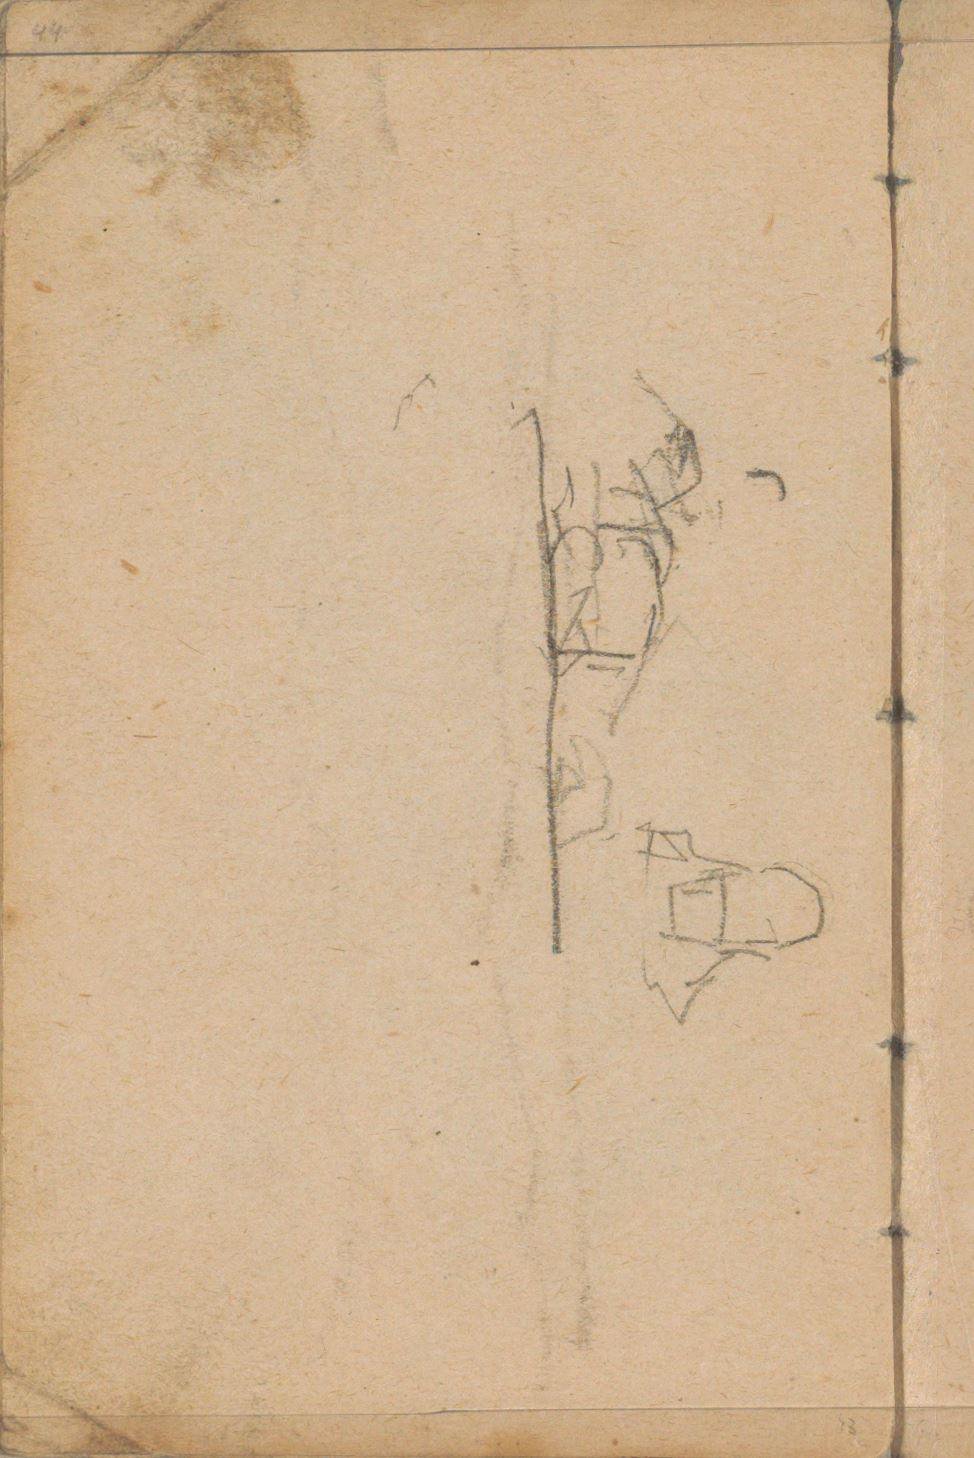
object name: sketchbook leaf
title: Studie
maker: george hendrik breitner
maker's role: draughtsman, painter, print maker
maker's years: 1857-1923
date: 1881-1883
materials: chalk, paper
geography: south holland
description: Studie. Pagina 44 uit een schetsboek met 43 bladen.